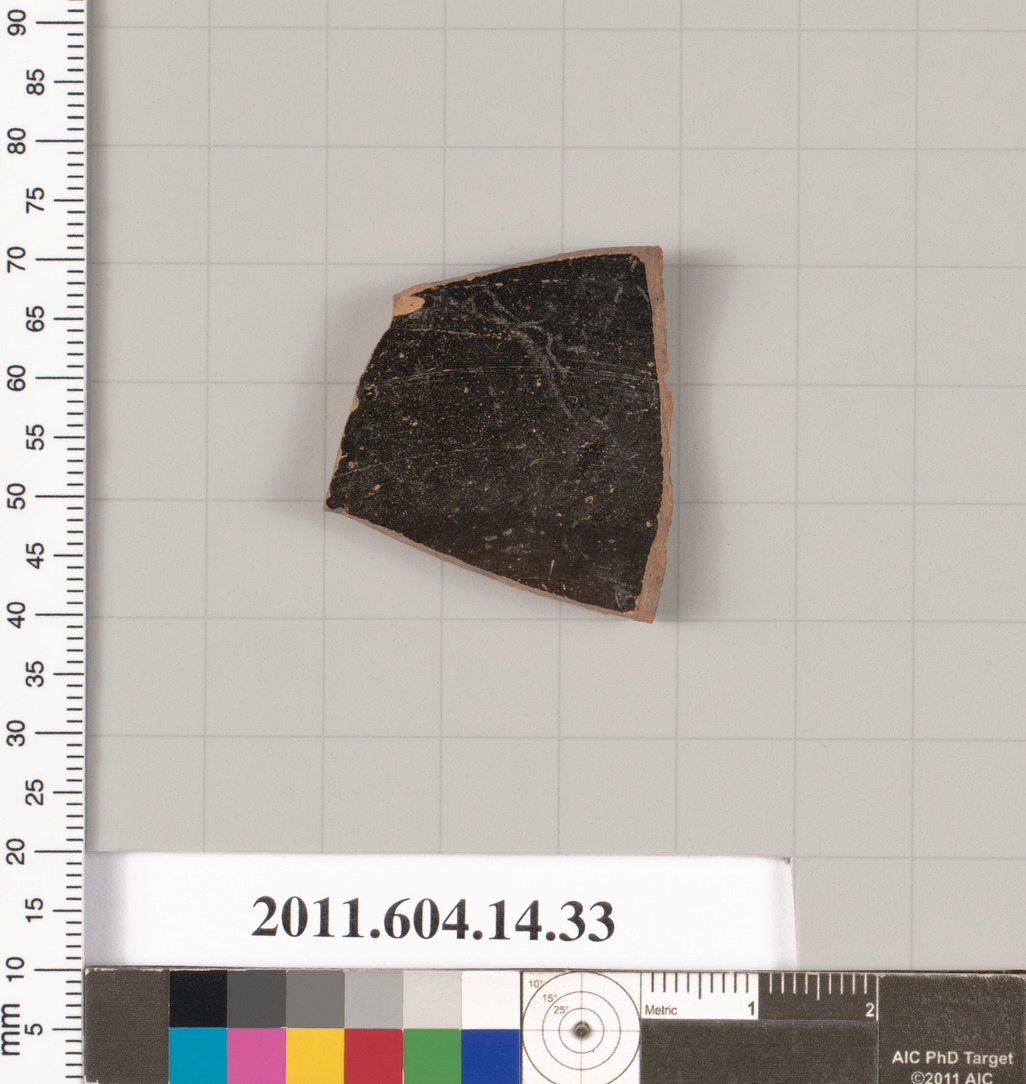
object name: kylix fragment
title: Terracotta fragment of a kylix (drinking cup)?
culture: unknown fabric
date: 600-401 BCE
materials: terracotta